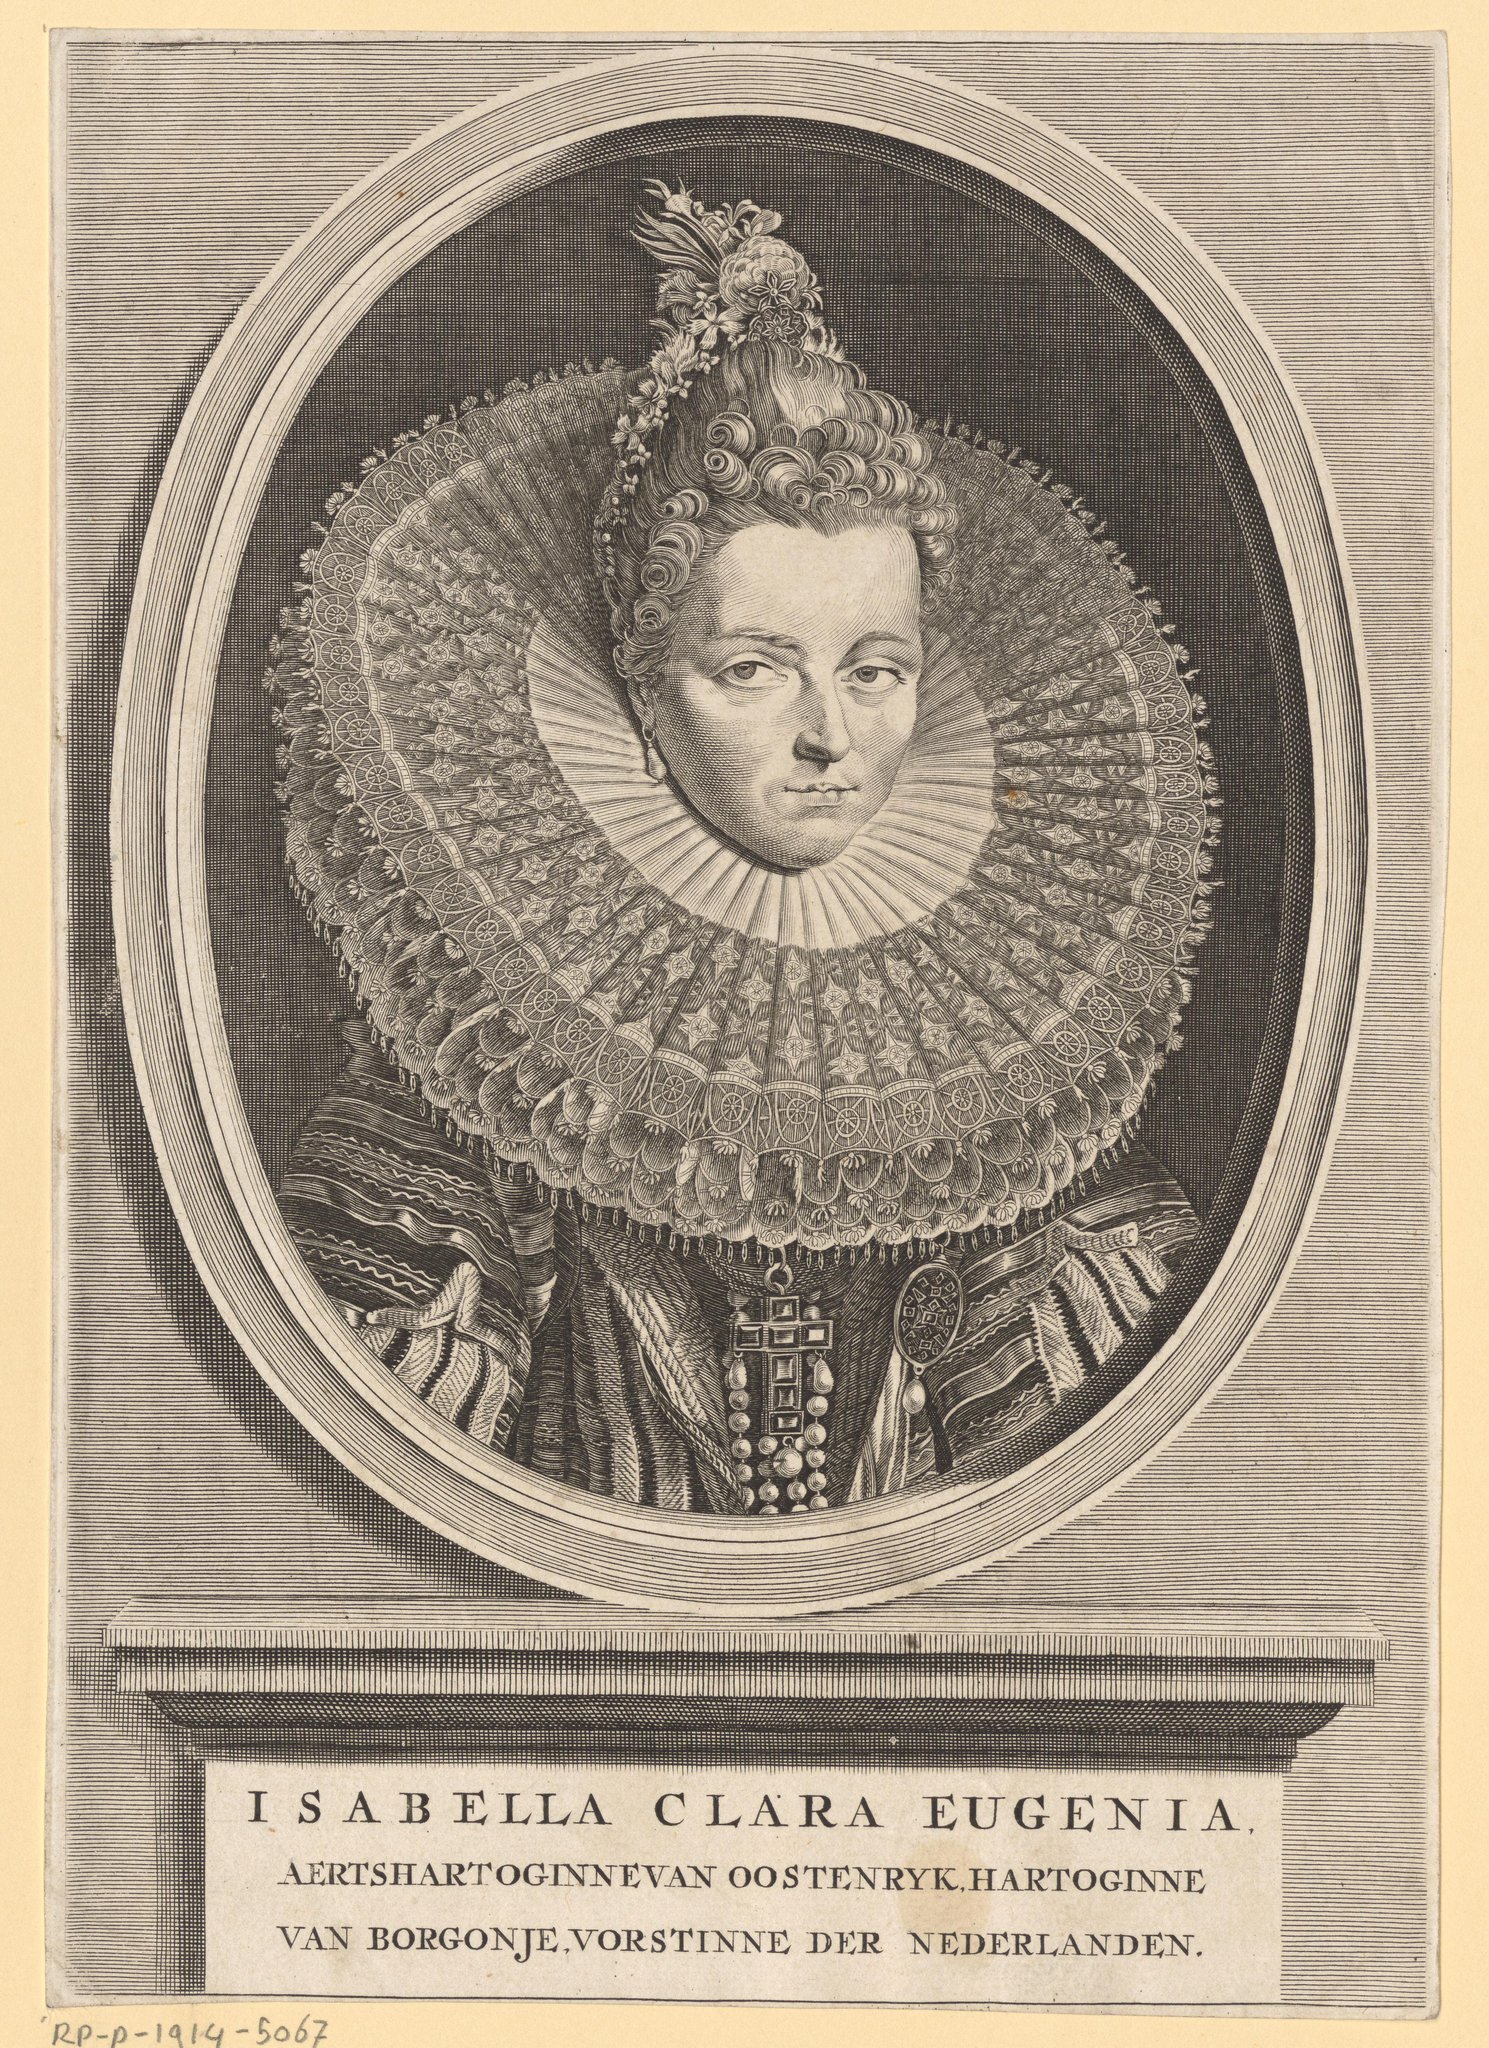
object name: print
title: Portret van Isabella Clara Eugenia, infante van Spanje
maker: Anonymous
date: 1684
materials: paper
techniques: engraving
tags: infante van spanje isabella clara eugenia, historical persons - bb - woman, ruler, sovereign - bb - female ruler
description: Prent waarschijnlijk uit: Bor, Pieter. Oorsprongk, begin, en vervolgh der Nederlandsche oorlogen, beroerten (...). Amsterdam: weduwe Joannes van Someren et al.,1684. Prent ook gebruikt in: Leti, Gregorio. Teatro Belgico, o vero ritratti historici (...). Amsterdam: Willem de Jonge, 1690, p. 127. Latere staat gebruikt in: Le Clerc, Jean. Geschiedenissen der Vereenigde Nederlanden (...). Amsterdam: Zacharias Chatelain, 1730.